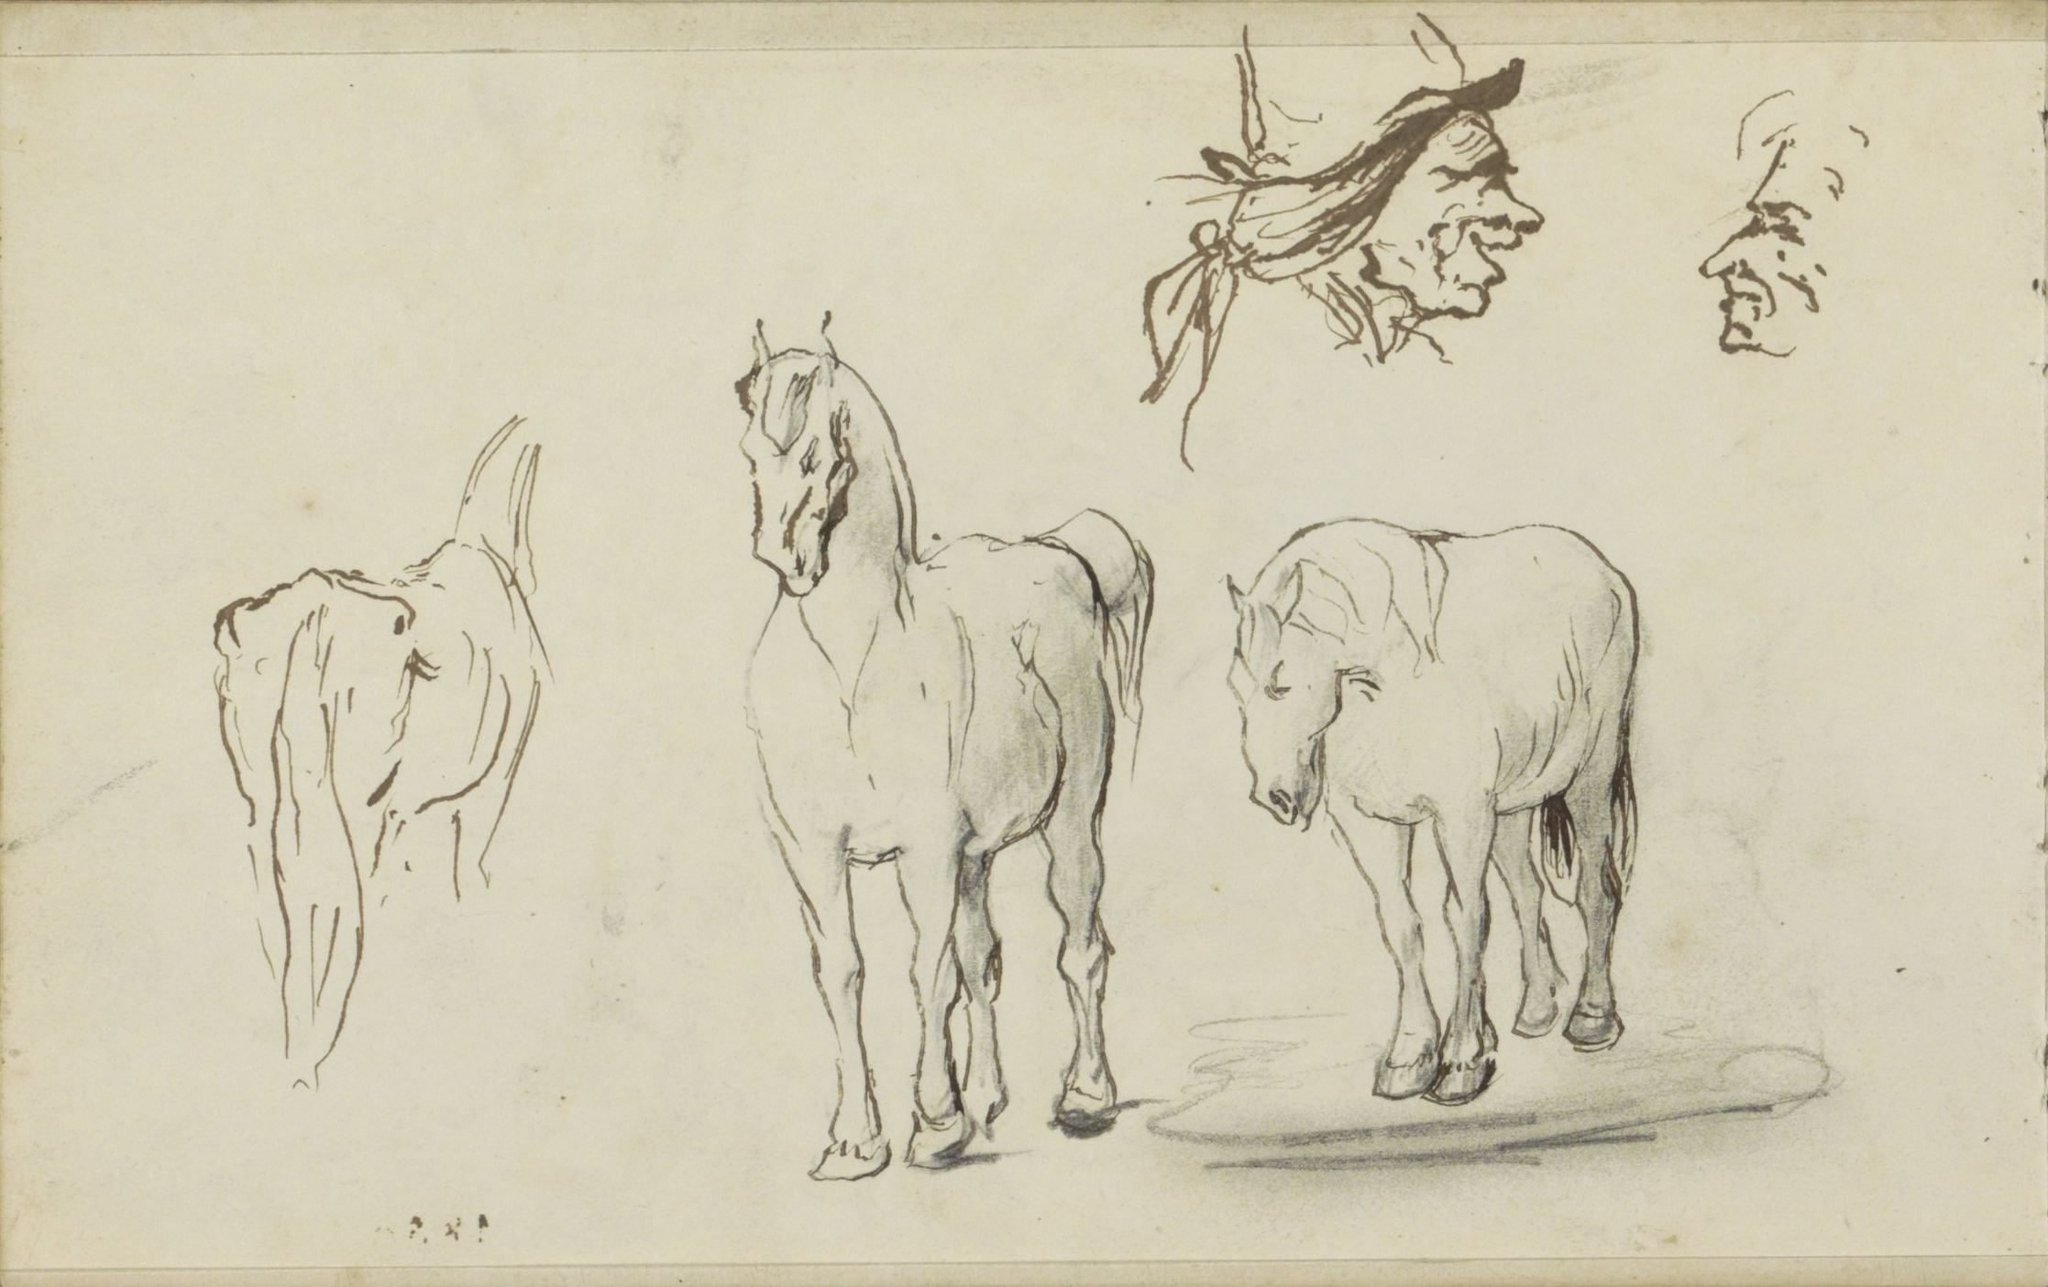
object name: sketchbook leaf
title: Studieblad, onder andere met paarden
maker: johannes tavenraat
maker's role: draughtsman, painter, print maker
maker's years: 1809-1881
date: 1839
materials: paper, pencil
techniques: pen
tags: head (human), adult man, horse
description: Tevens twee studies van mannenkoppen. Blad 4 verso uit een schetsboek met 37 bladen.